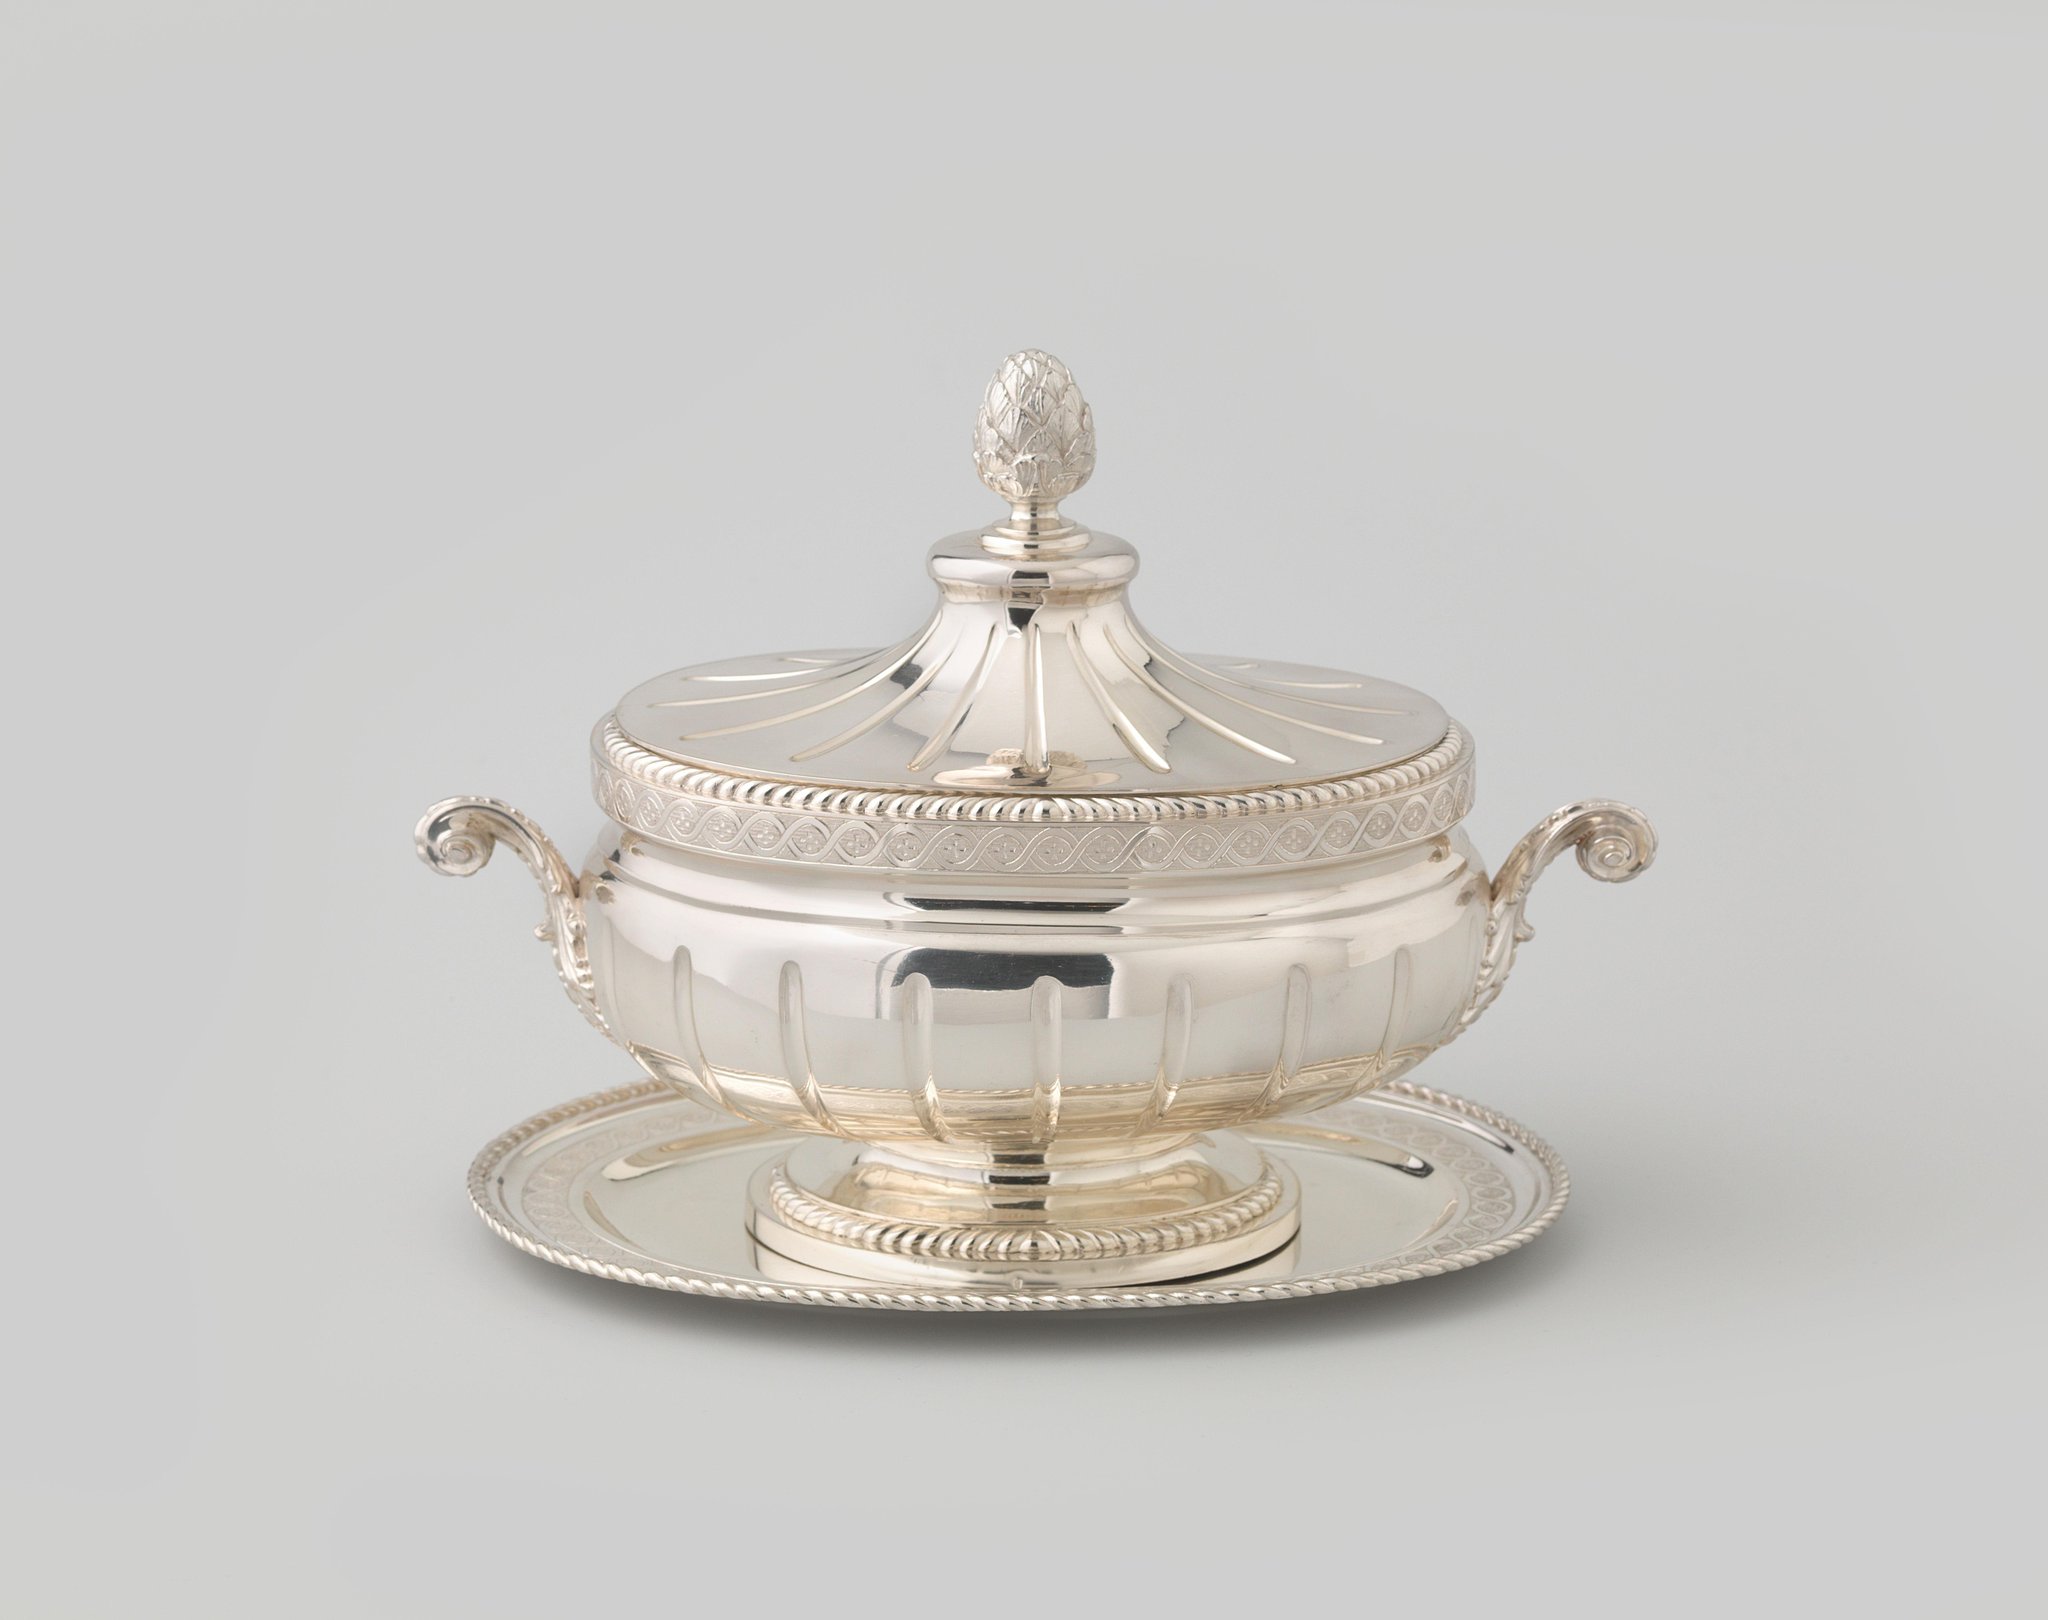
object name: platter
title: Ovale onderschotel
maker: fredrik manicus (i)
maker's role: silversmith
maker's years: 1738-1785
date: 1776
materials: silver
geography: amsterdam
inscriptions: maker's mark, : ‘L’, town mark, alloy mark, date letter: ‘R’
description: De ovale terrine heeft een eveneens ovale onderschotel en een los deksel. Het plat van de onderschotel wordt omgeven door een iets verhoogde, brede rand met een gegraveerde versiering van twee rond een reeks rozetten geslingerde linten tegen een in glanssteek gearceerde achtergrond. Daaromheen loopt een nog weer hogere rand, die langs de buitenzijde wordt afgesloten door een kabelrand. De terrine rust op een rechtwandige basis. Langs de onderrand van de ingesnoerde voet is een versiering van schuin geplaatste knorren aangebracht. Het bol gewelfde, gecanneleerde lichaam wordt door een ingesnoerd gedeelte verbonden met de rechtwandige bekroning. Deze heeft een zelfde gegraveerde versiering als de onderschotel en een vlakke bovenzijde, waarop de mondrand, versierd met schuin geplaatste knerren, is aangebracht. Hierin past het gewelfde, zich verjongende deksel, dat gecanneleerd is. Aan de bovenzijde verbreedt het zich tot een podium, waarop de dekselknop rust, die de vorm heeft van een dennenappel op een ingesnoerde, geprofileerde voet.